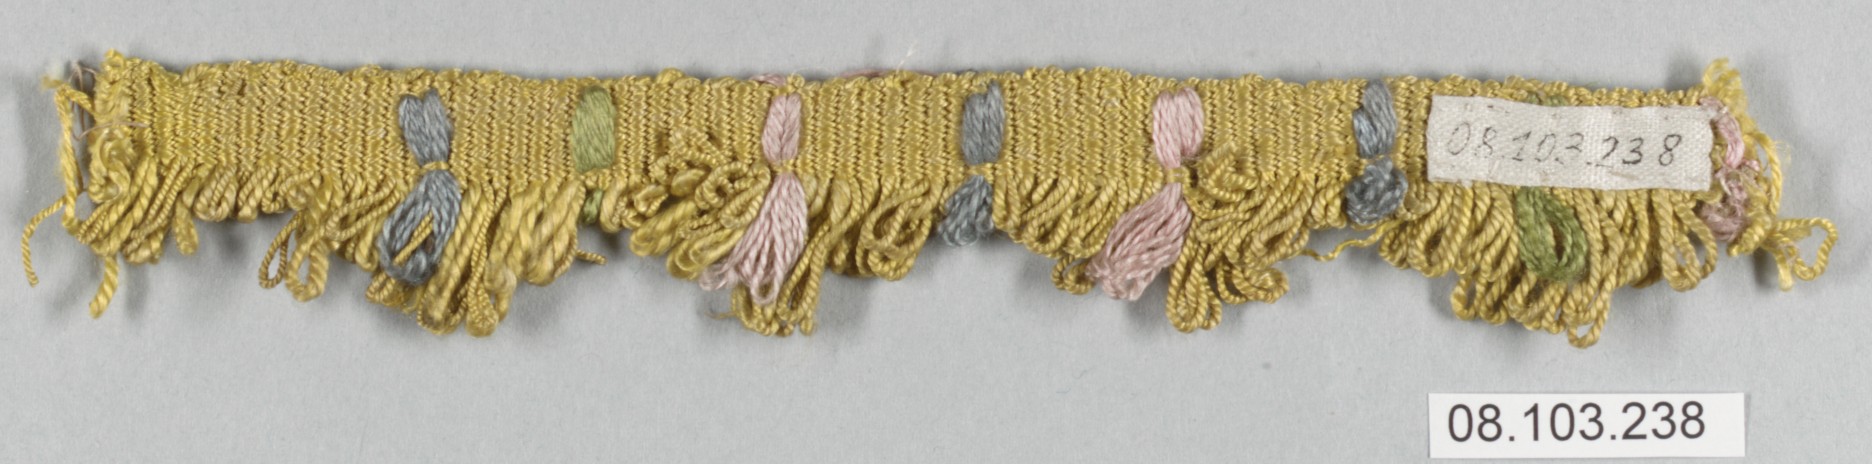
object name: gimp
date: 1601-1700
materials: silk